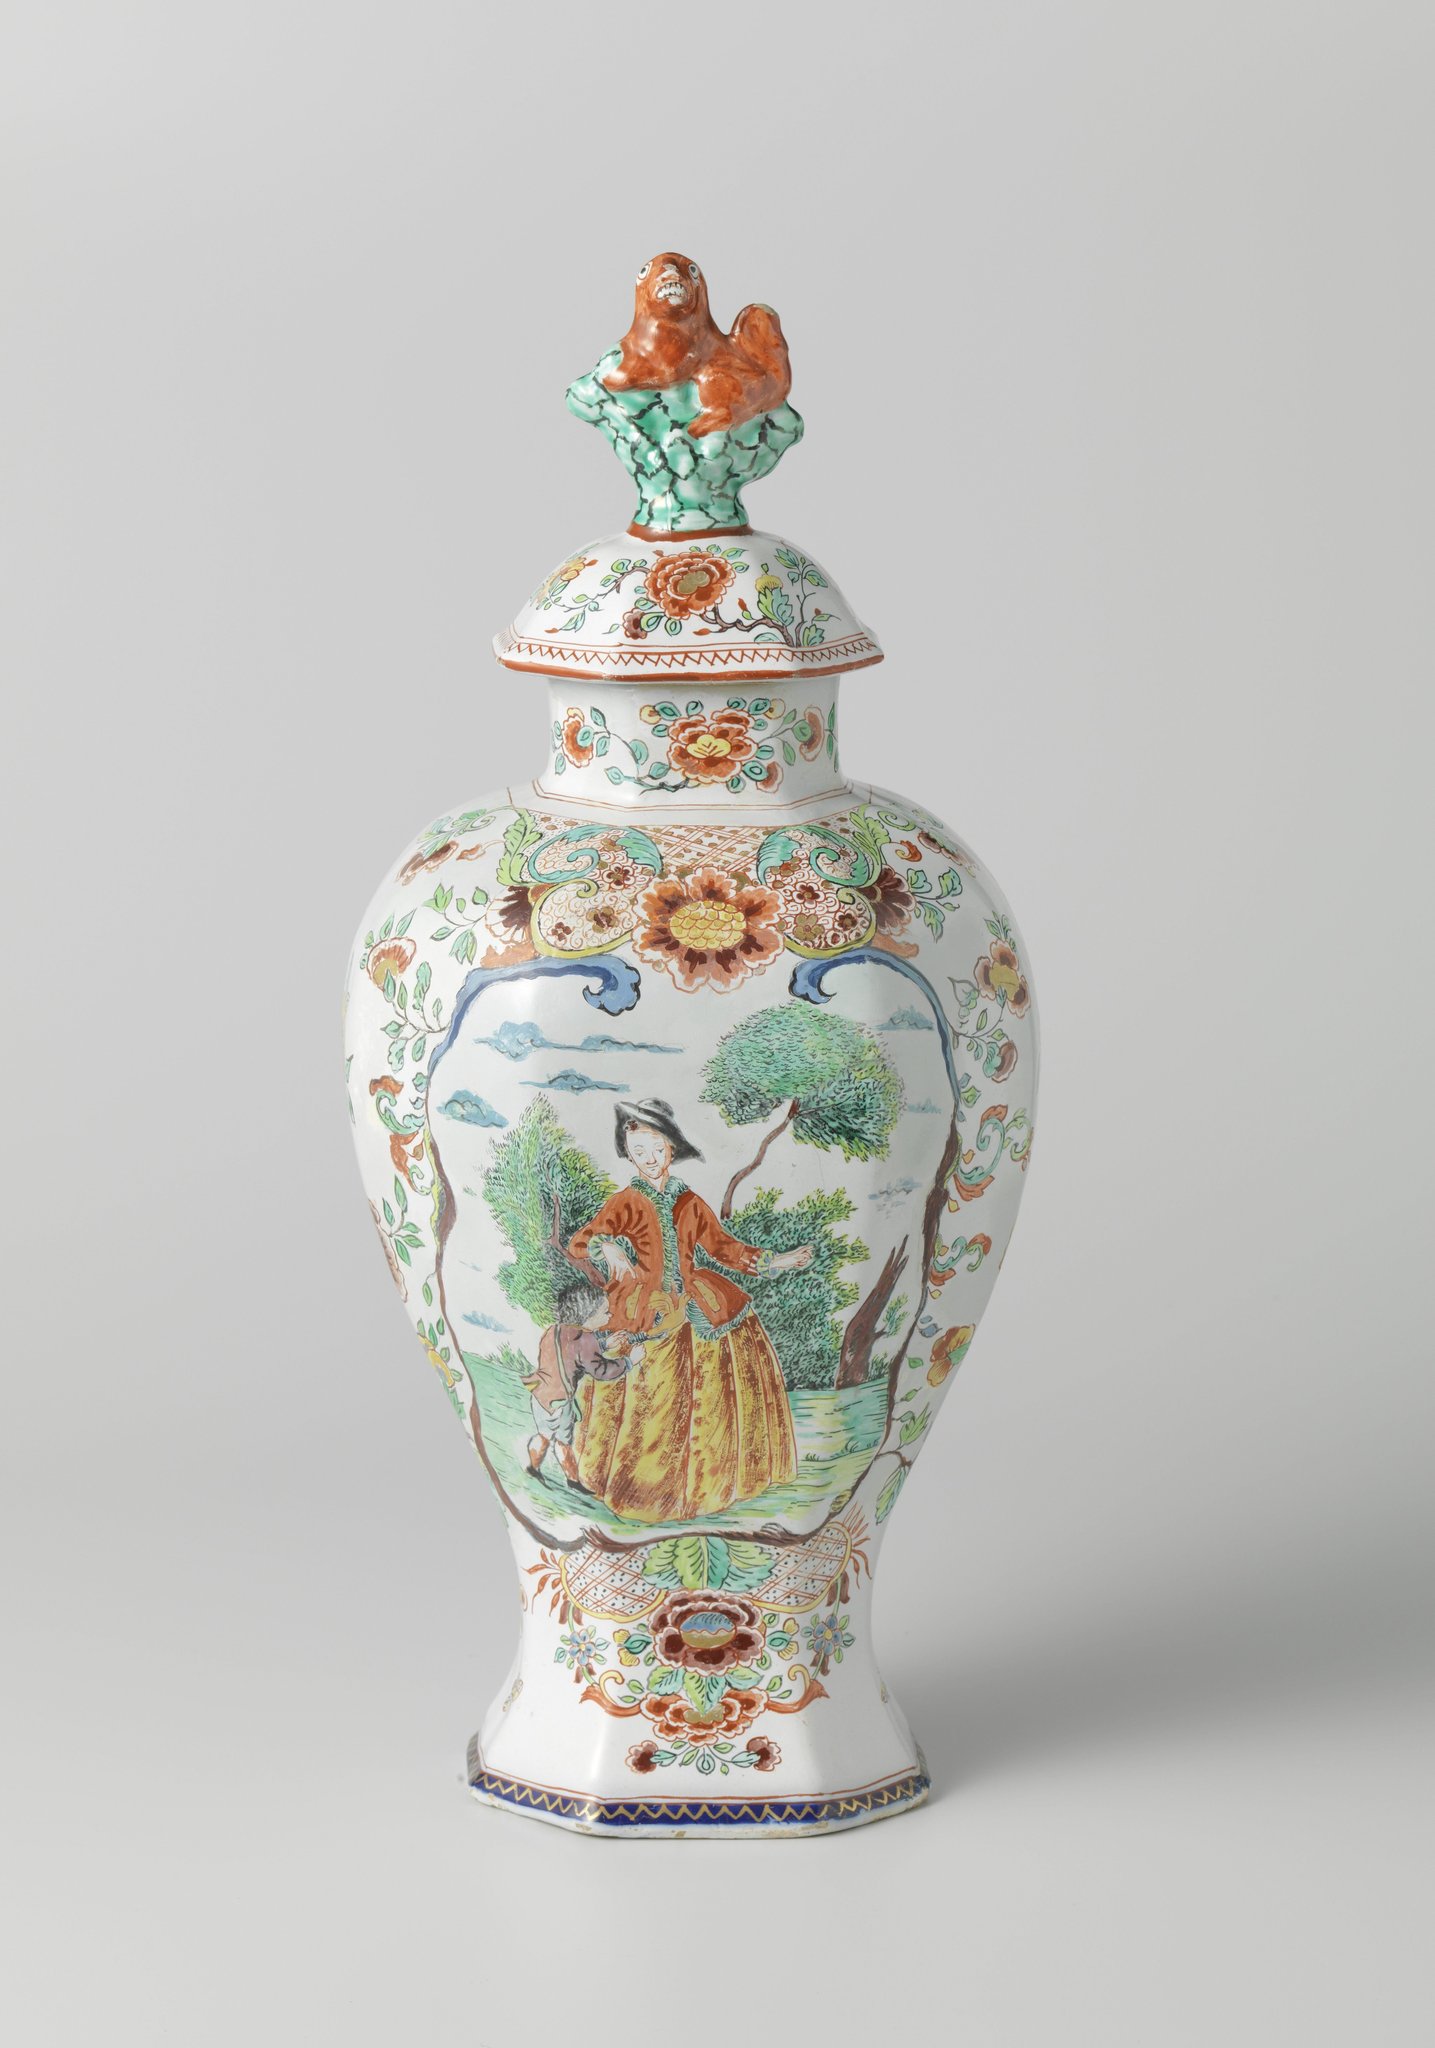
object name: lid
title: Deksel van een pot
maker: Anonymous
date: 1740-1760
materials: faience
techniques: kiln, painted, polychromy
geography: delft